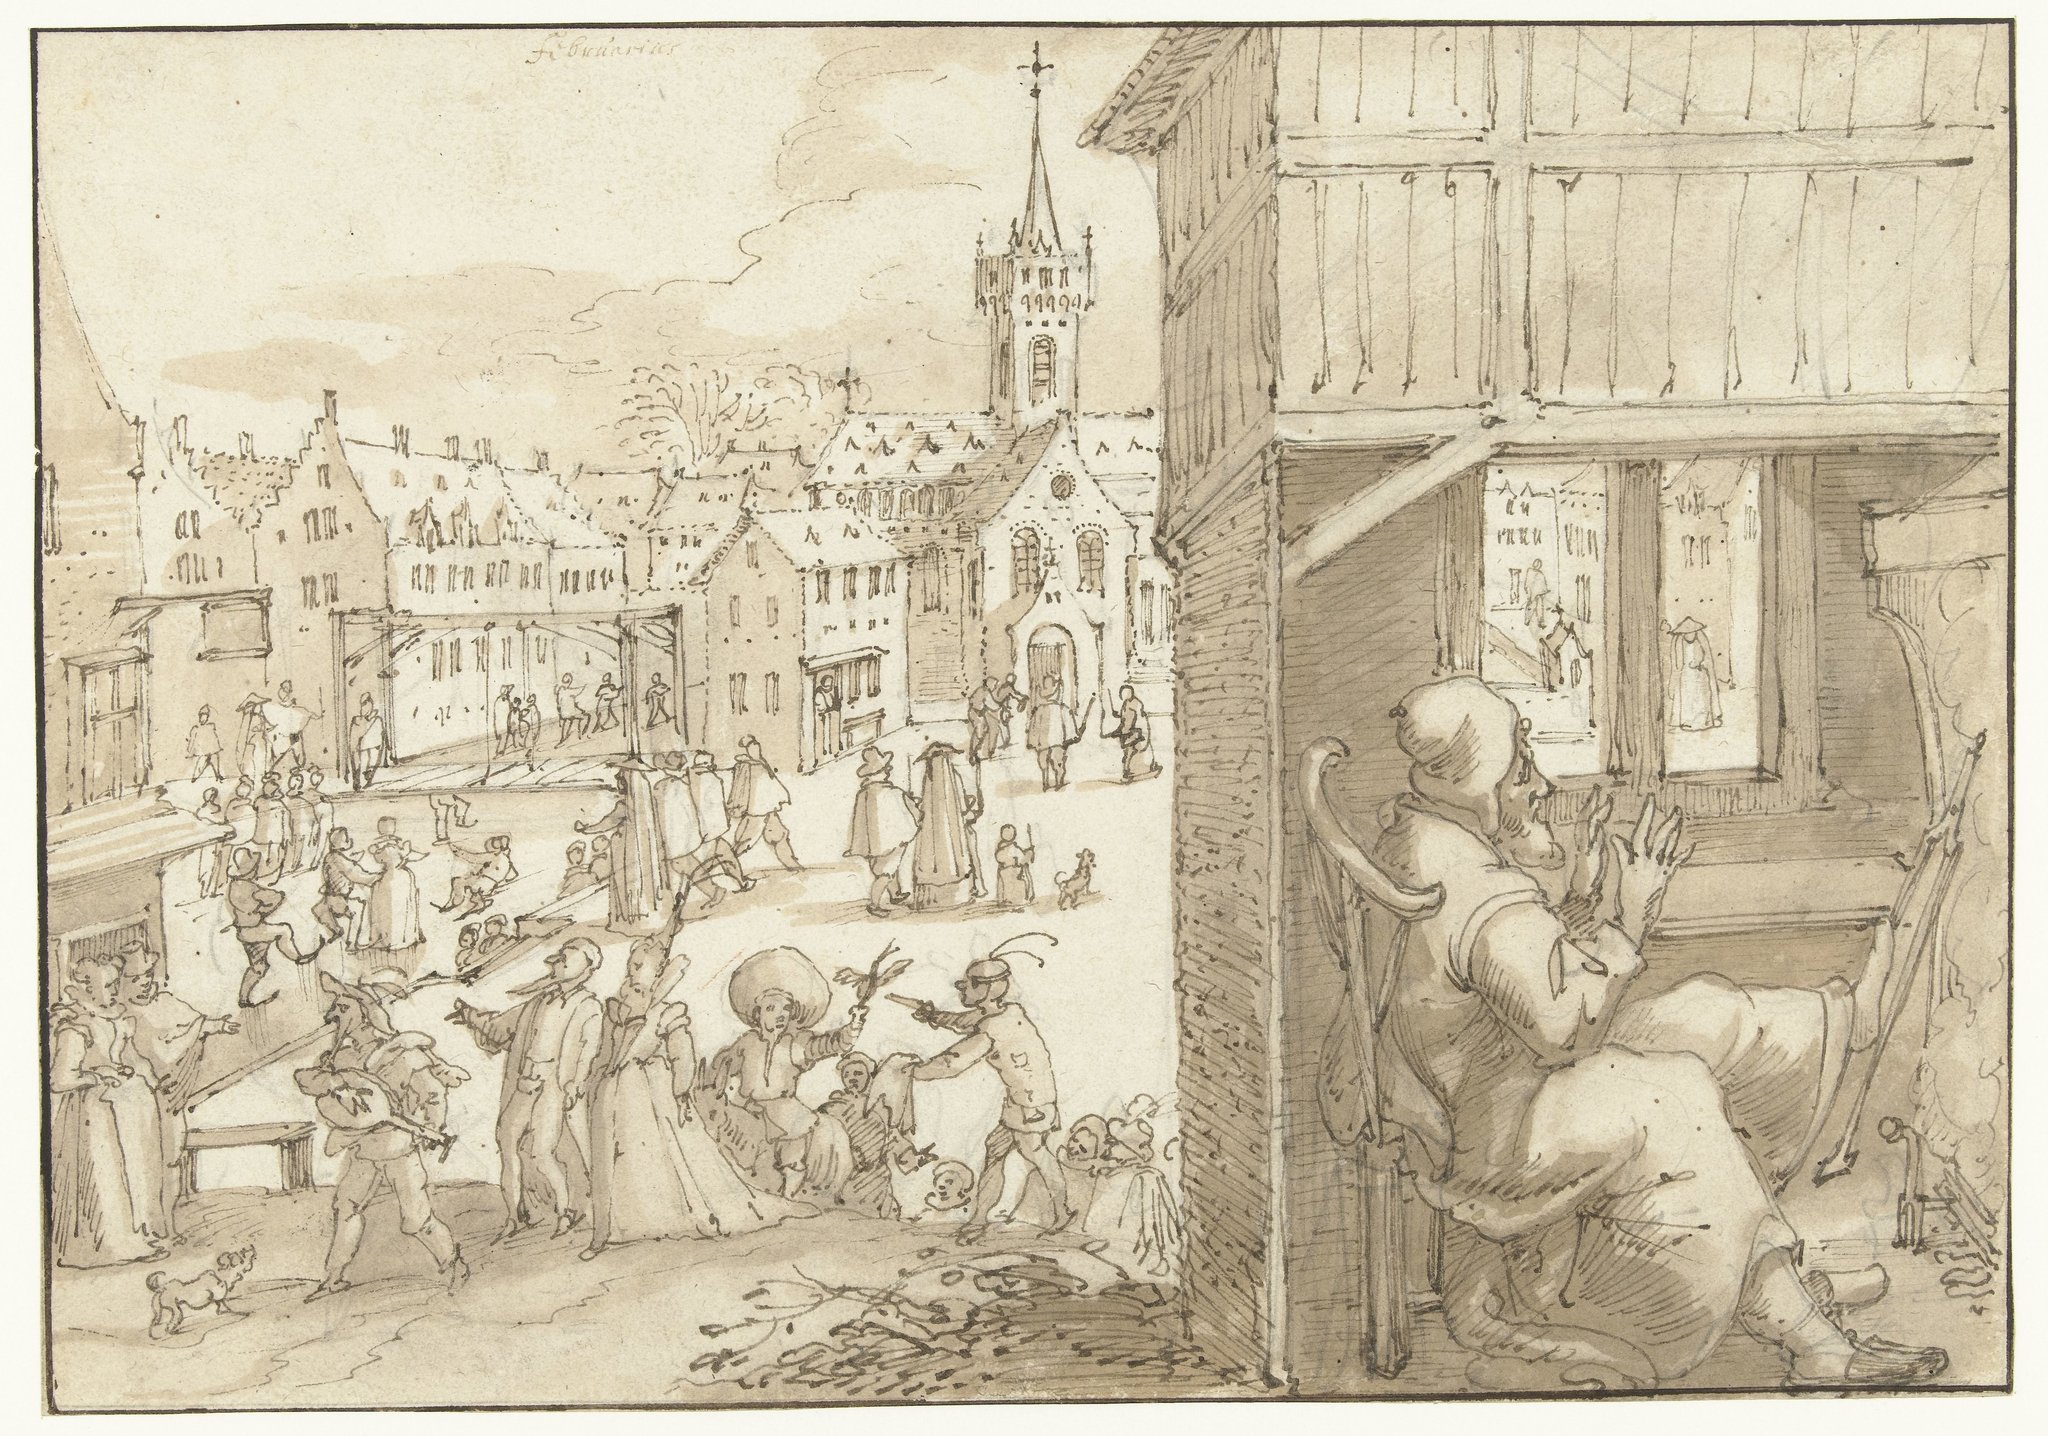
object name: design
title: Februari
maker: joos de momper (ii)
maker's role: draughtsman, painter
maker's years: 1564-1635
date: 1590-1610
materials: chalk, ink, paper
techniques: brush, pen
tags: square, place, circus, etc., february and its 'labours', warming oneself at a fire (or hearth, stove, fire-pan, brazier)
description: De maand februari. Links lopen mensen op een plein, rechts zit een man binnen bij een vuur. Ontwerp voor een prent.